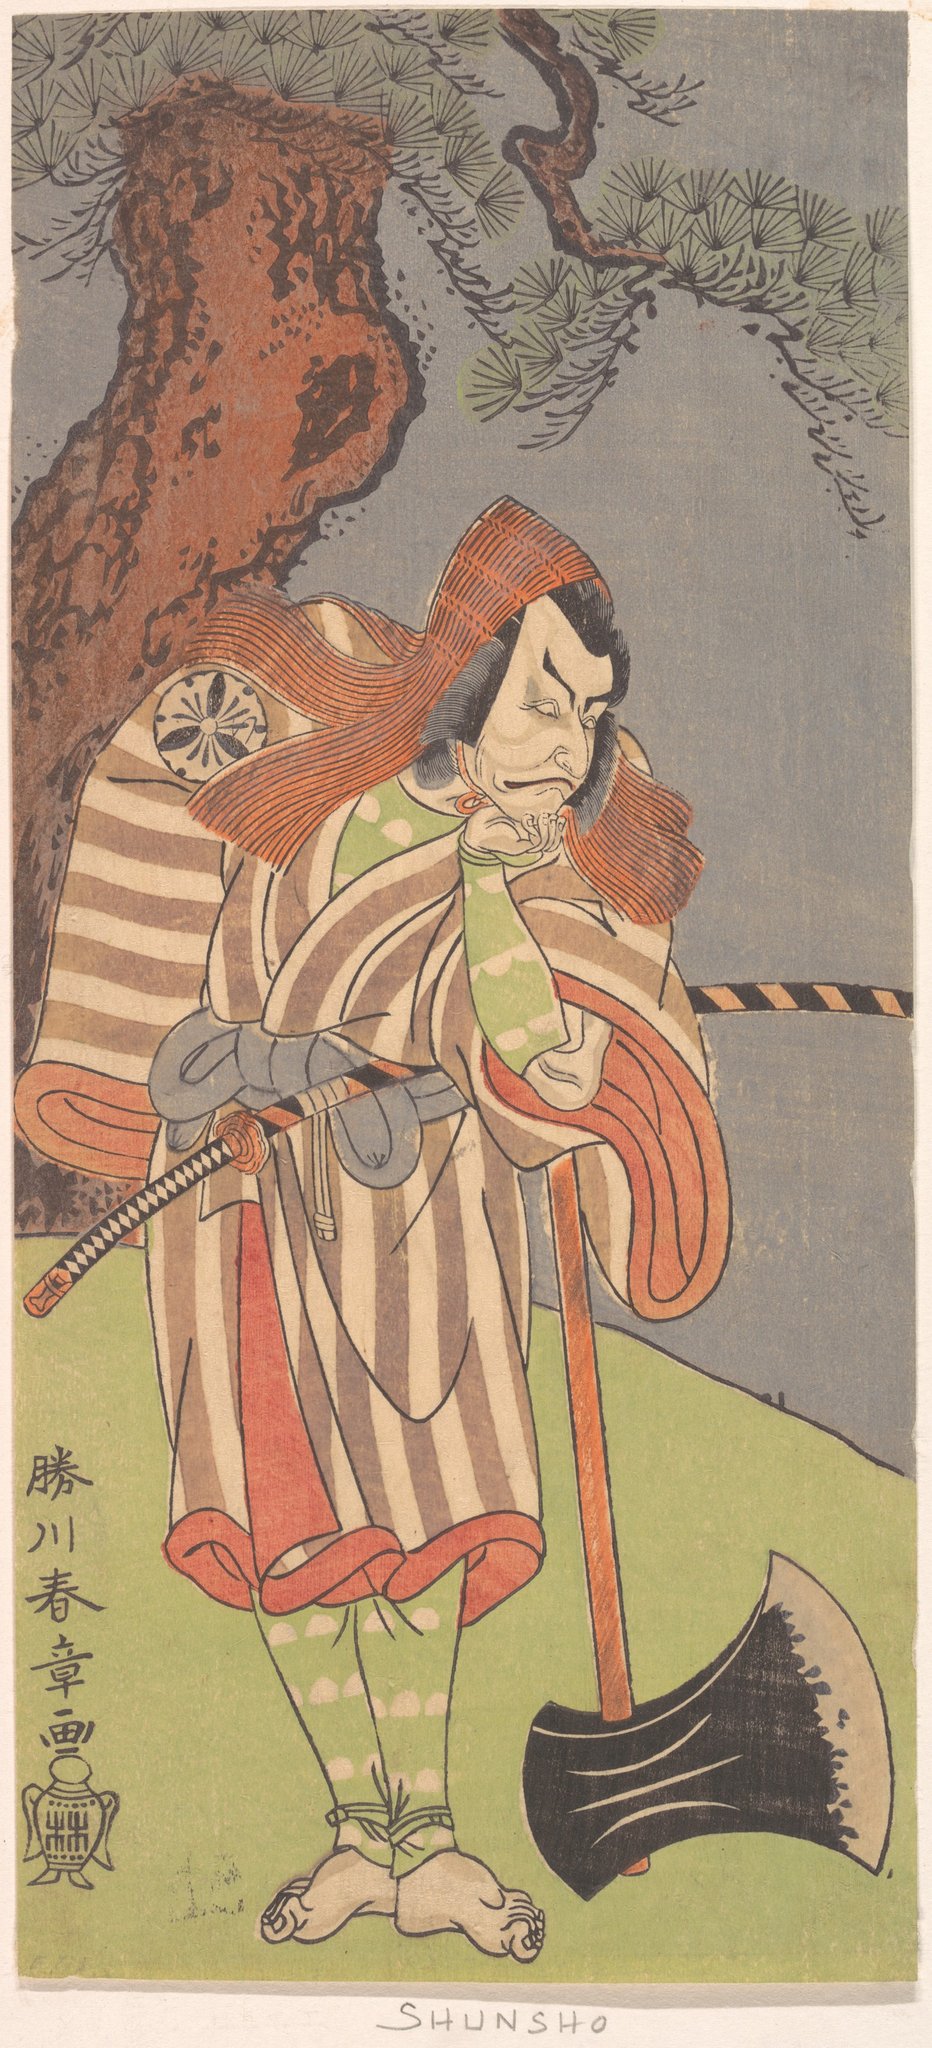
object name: woodblock print nishiki e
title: The Actor the Fourth Danjuro with His Chin in His Hand Leaning on the Handle of a Large Black Axe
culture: japanese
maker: katsukawa shunshō 勝川春章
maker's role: artist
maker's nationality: japanese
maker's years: 1726-1792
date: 1770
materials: ink, paper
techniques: nishiki e, woodblock print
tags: swords,actors,axes